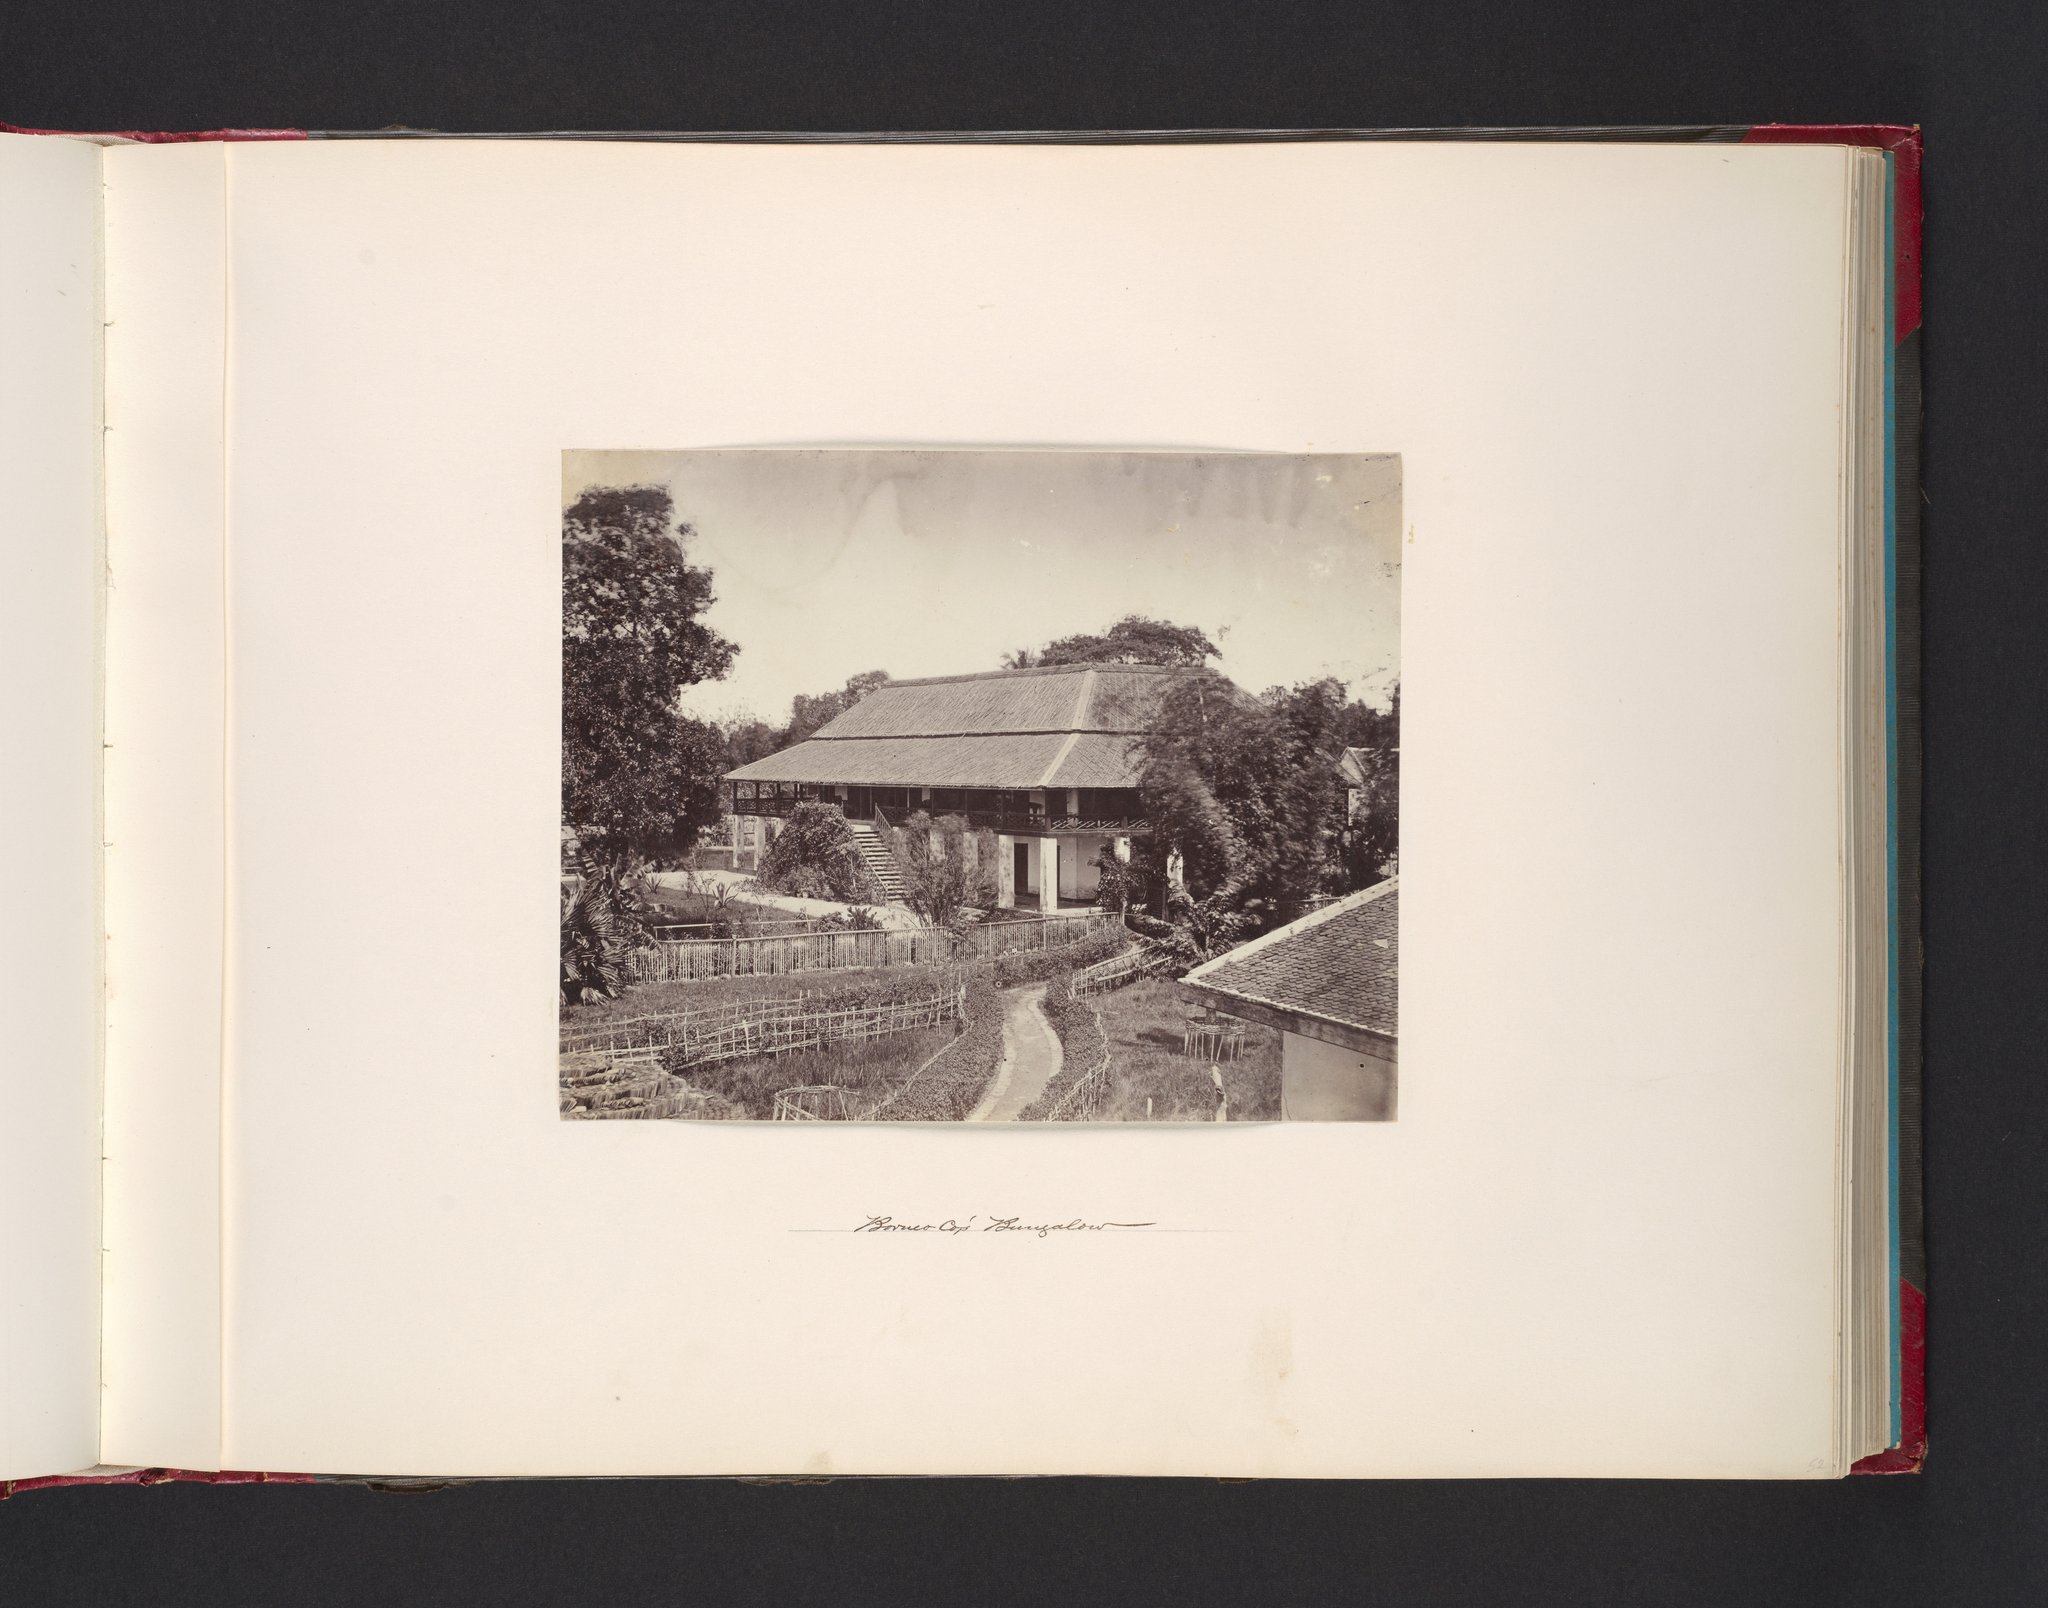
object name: photograph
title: Borneo Co. Bungalow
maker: john thomson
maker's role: artist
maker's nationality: british, scottish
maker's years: 1837-1921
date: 1865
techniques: albumen silver print, glass negative